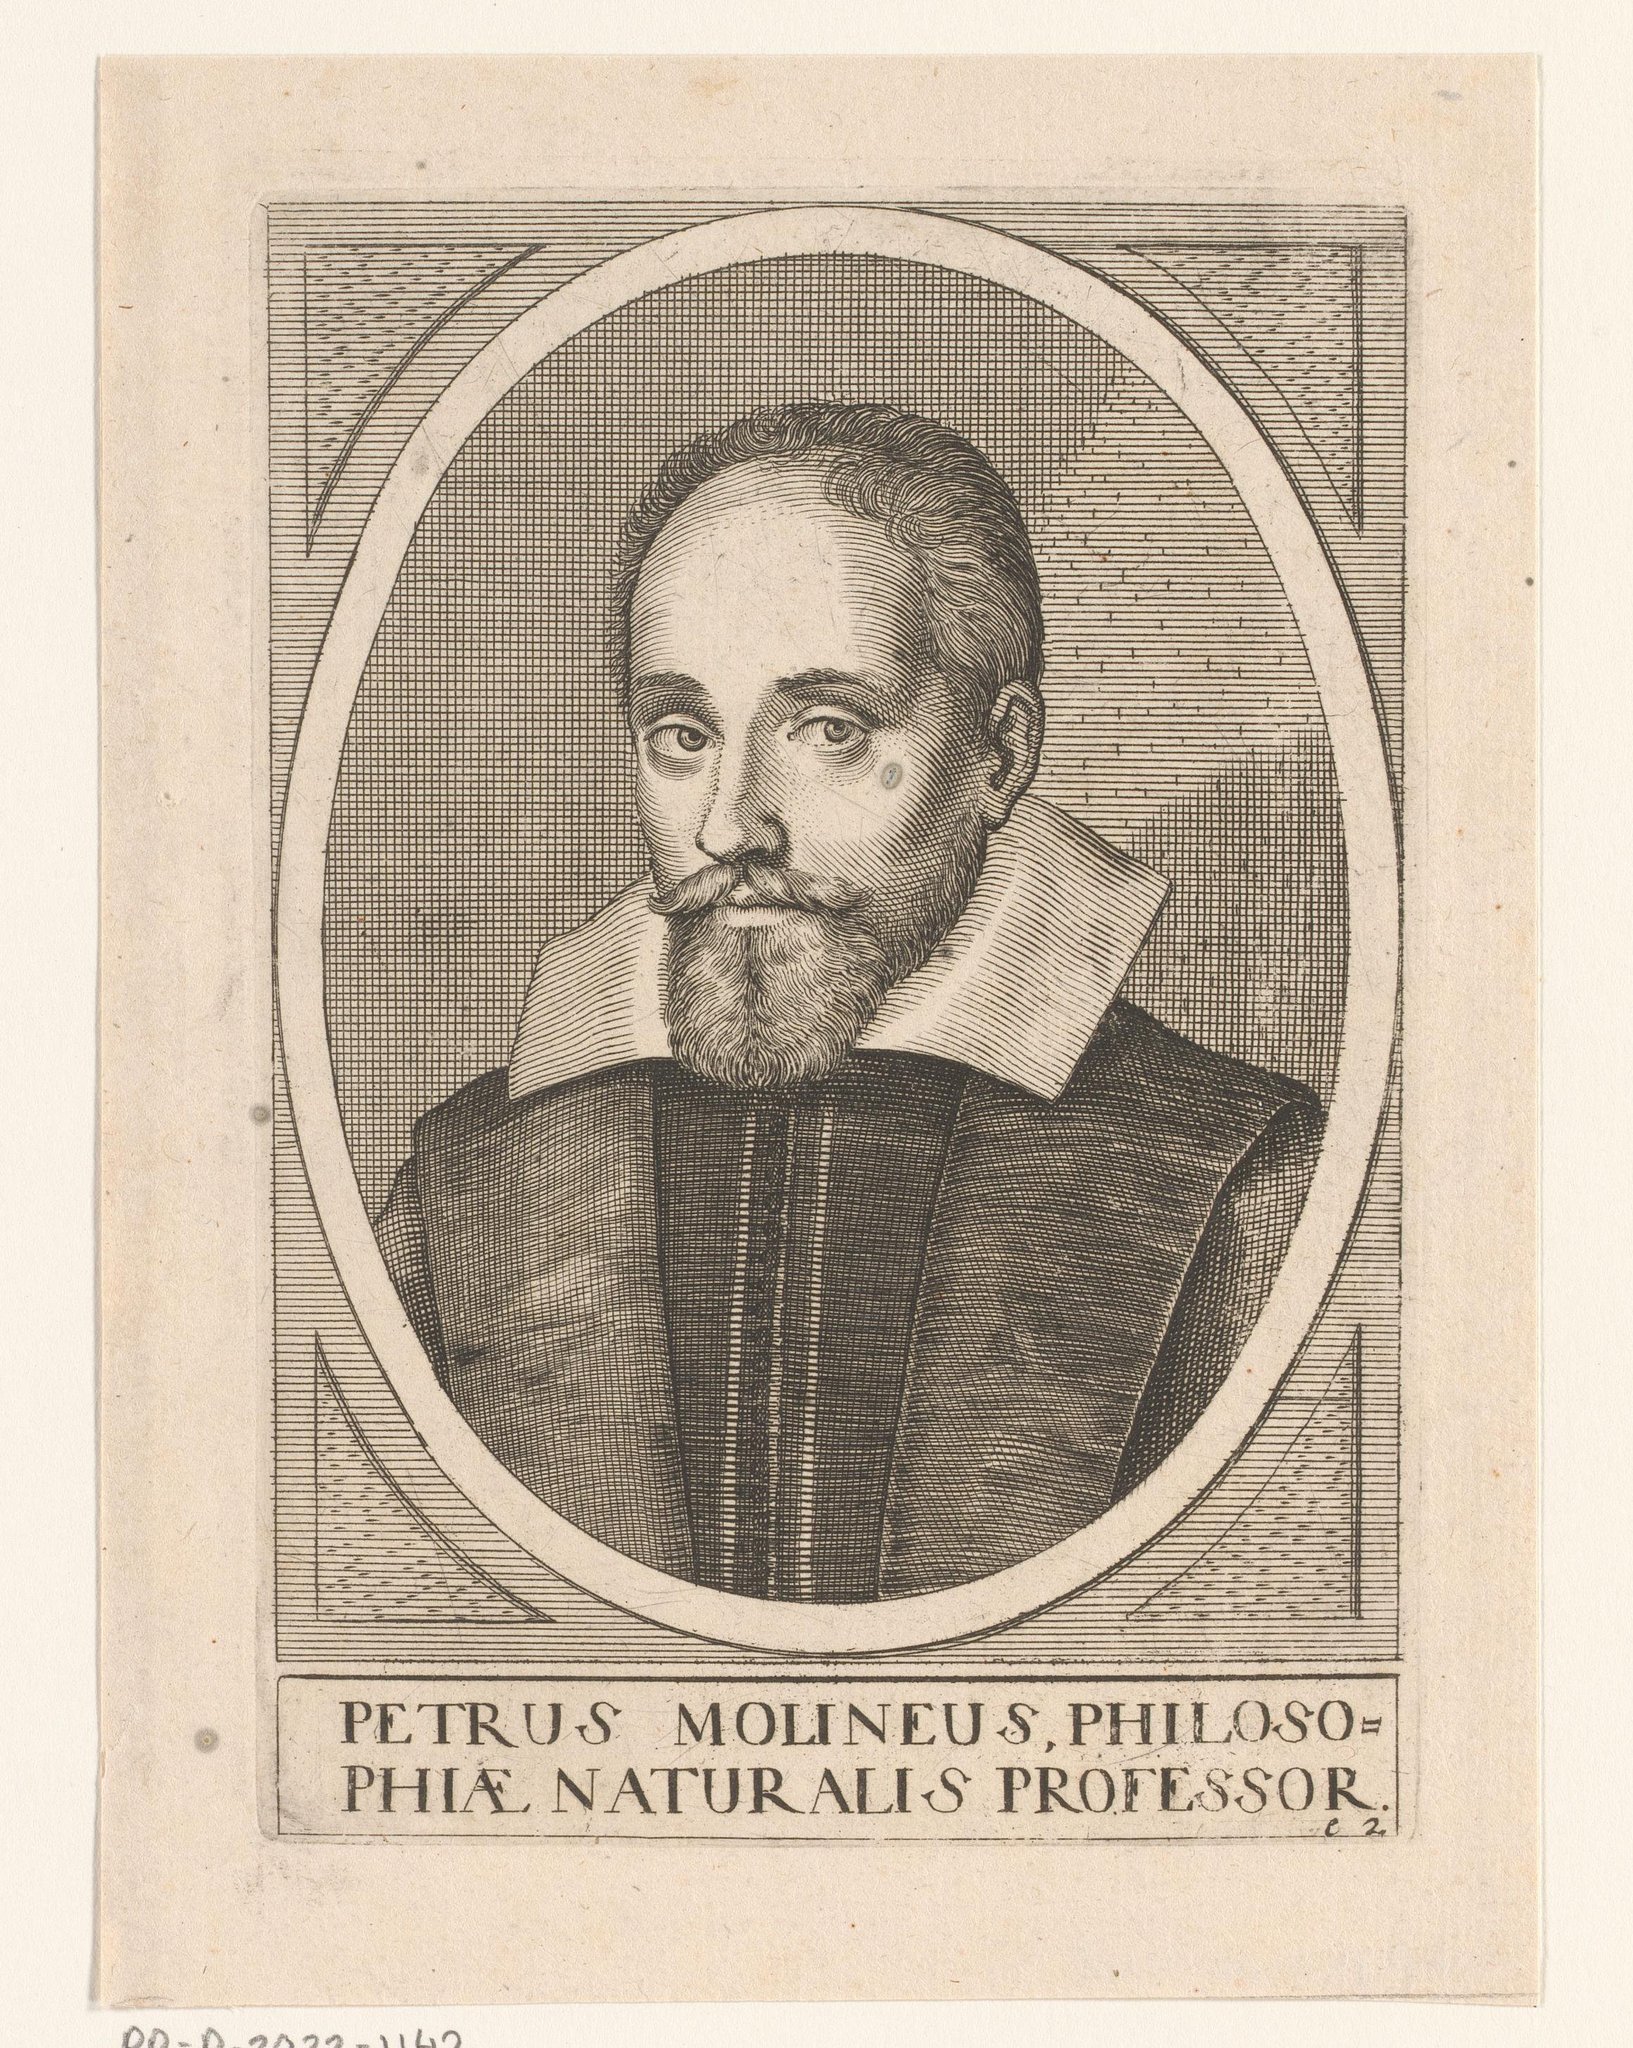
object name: book illustration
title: Petrus Molineus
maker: Anonymous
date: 1650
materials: paper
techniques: engraving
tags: minister ~ government, historical persons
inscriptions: collector's mark: Lugt 2228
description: Prent waarschijnlijk uit: Boissard, Jean Jacques. Bibliotheca chalcographica (...). Frankfurt am Main: Johannes Ammon, 1650, dl. 6.